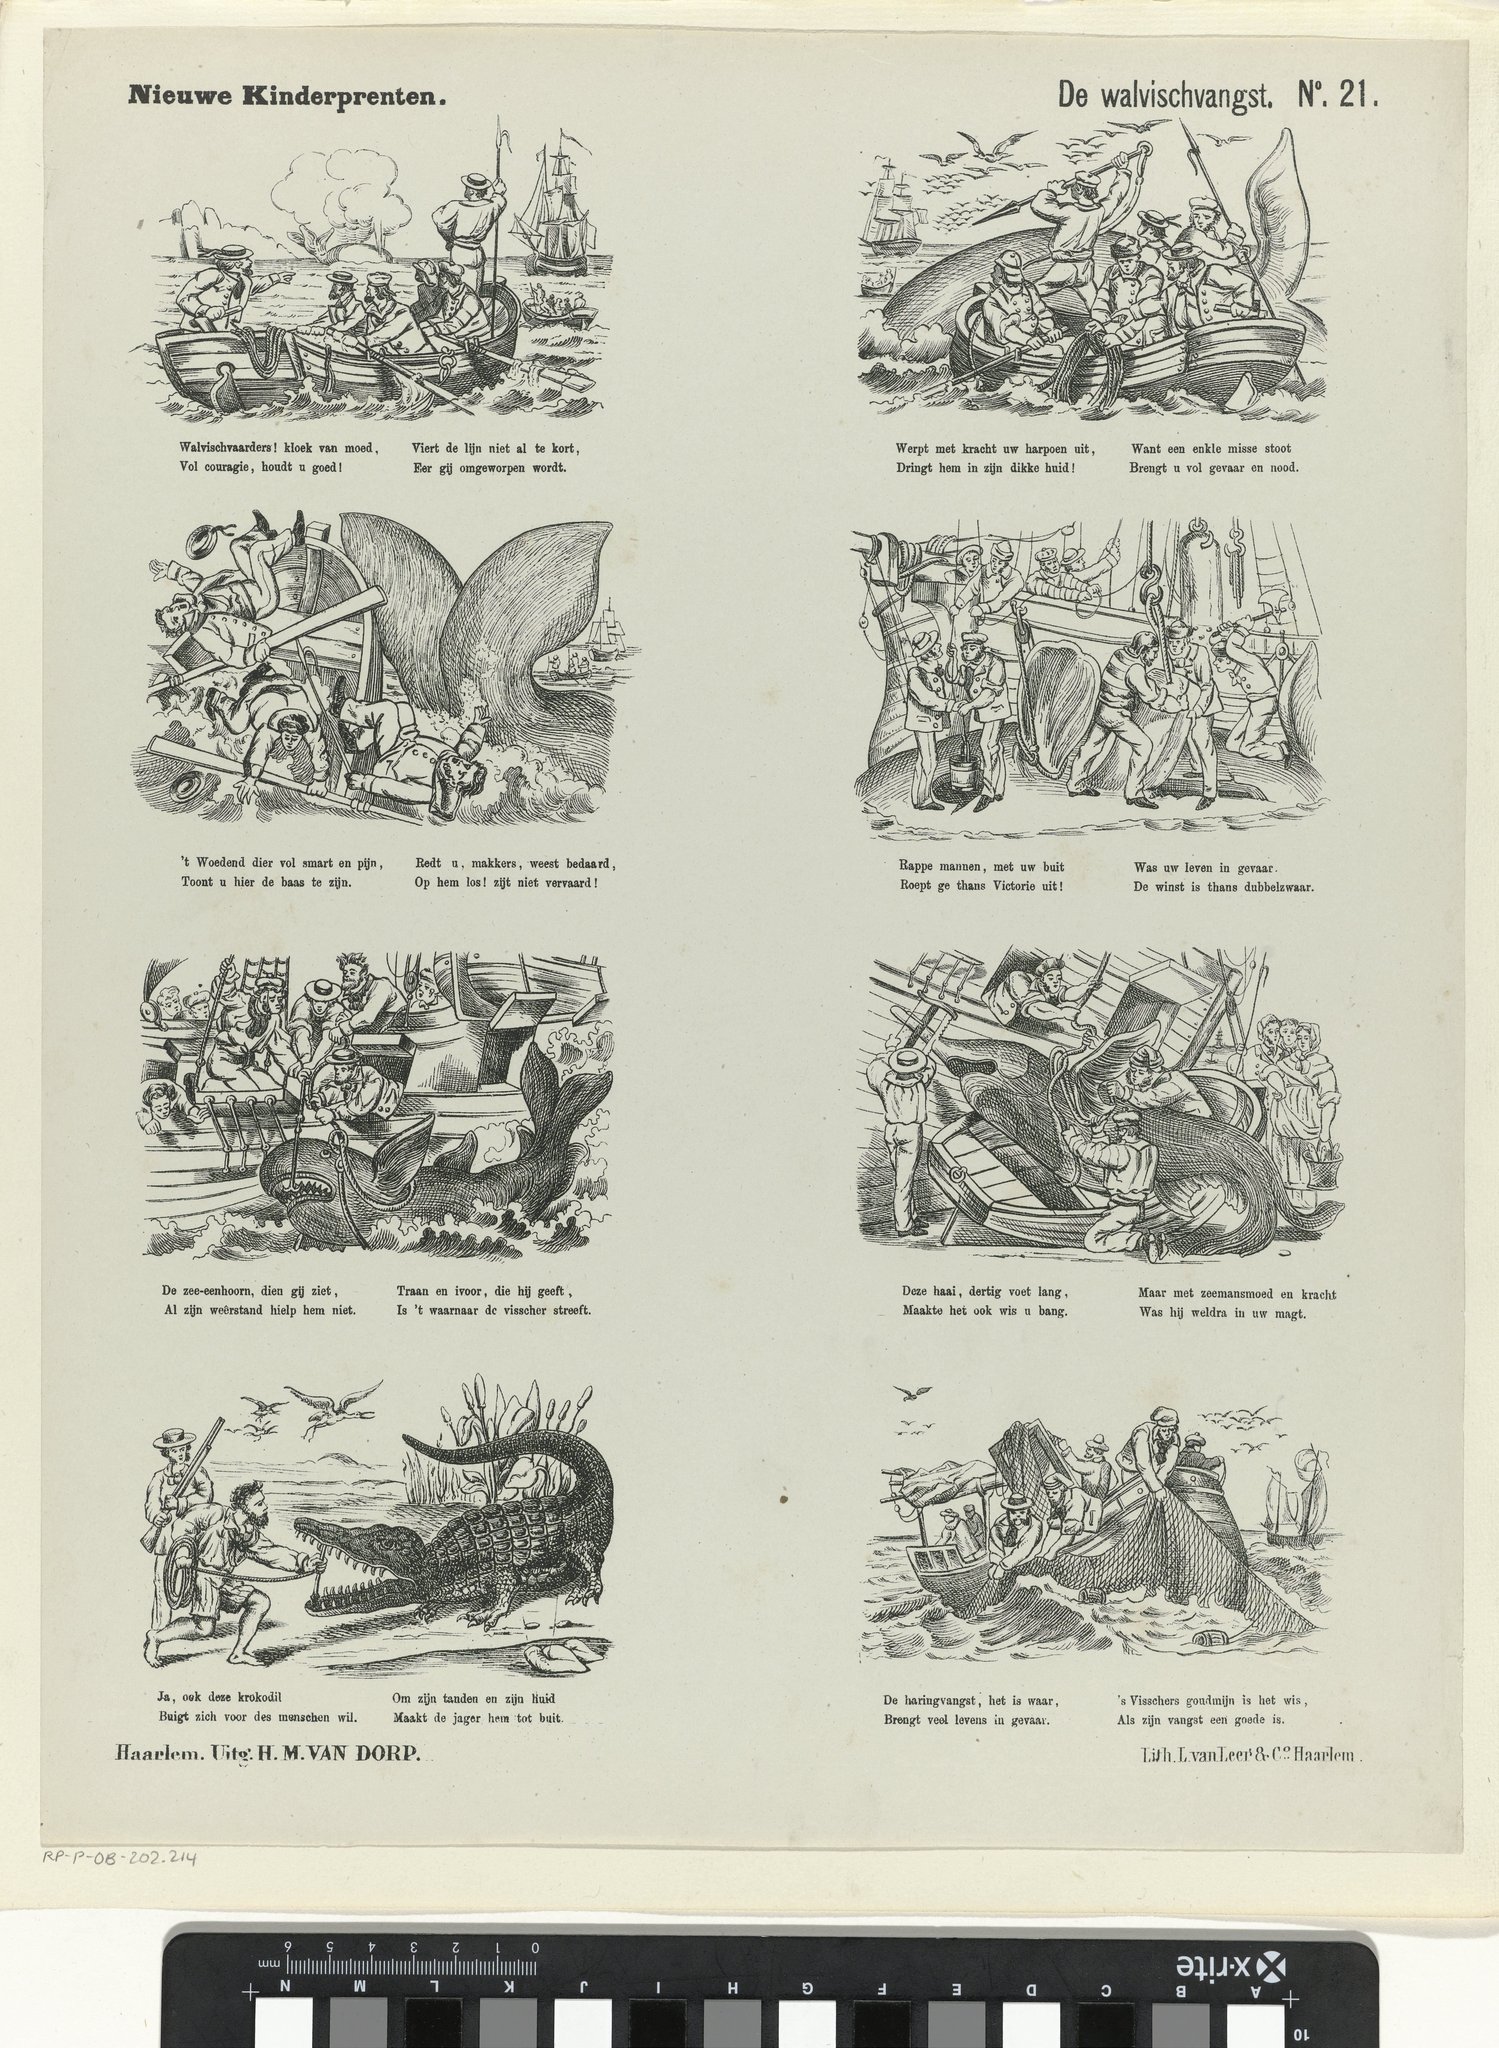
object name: print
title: De walvischvangst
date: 1872-1883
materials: paper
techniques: letterpress printing, lithograph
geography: haarlem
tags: commercial fishery, crocodiles: crocodile, herring fishery, whale fishery, whaling, fisherman, cartilaginous fishes: shark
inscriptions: collector's mark: Lugt 2760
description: Blad met 8 voorstellingen over het vangen van een walvis, een haai een krokodil en vissen. Onder elke afbeelding een vierregelig vers in twee kolommen. Genummerd rechtsboven: No. 21.